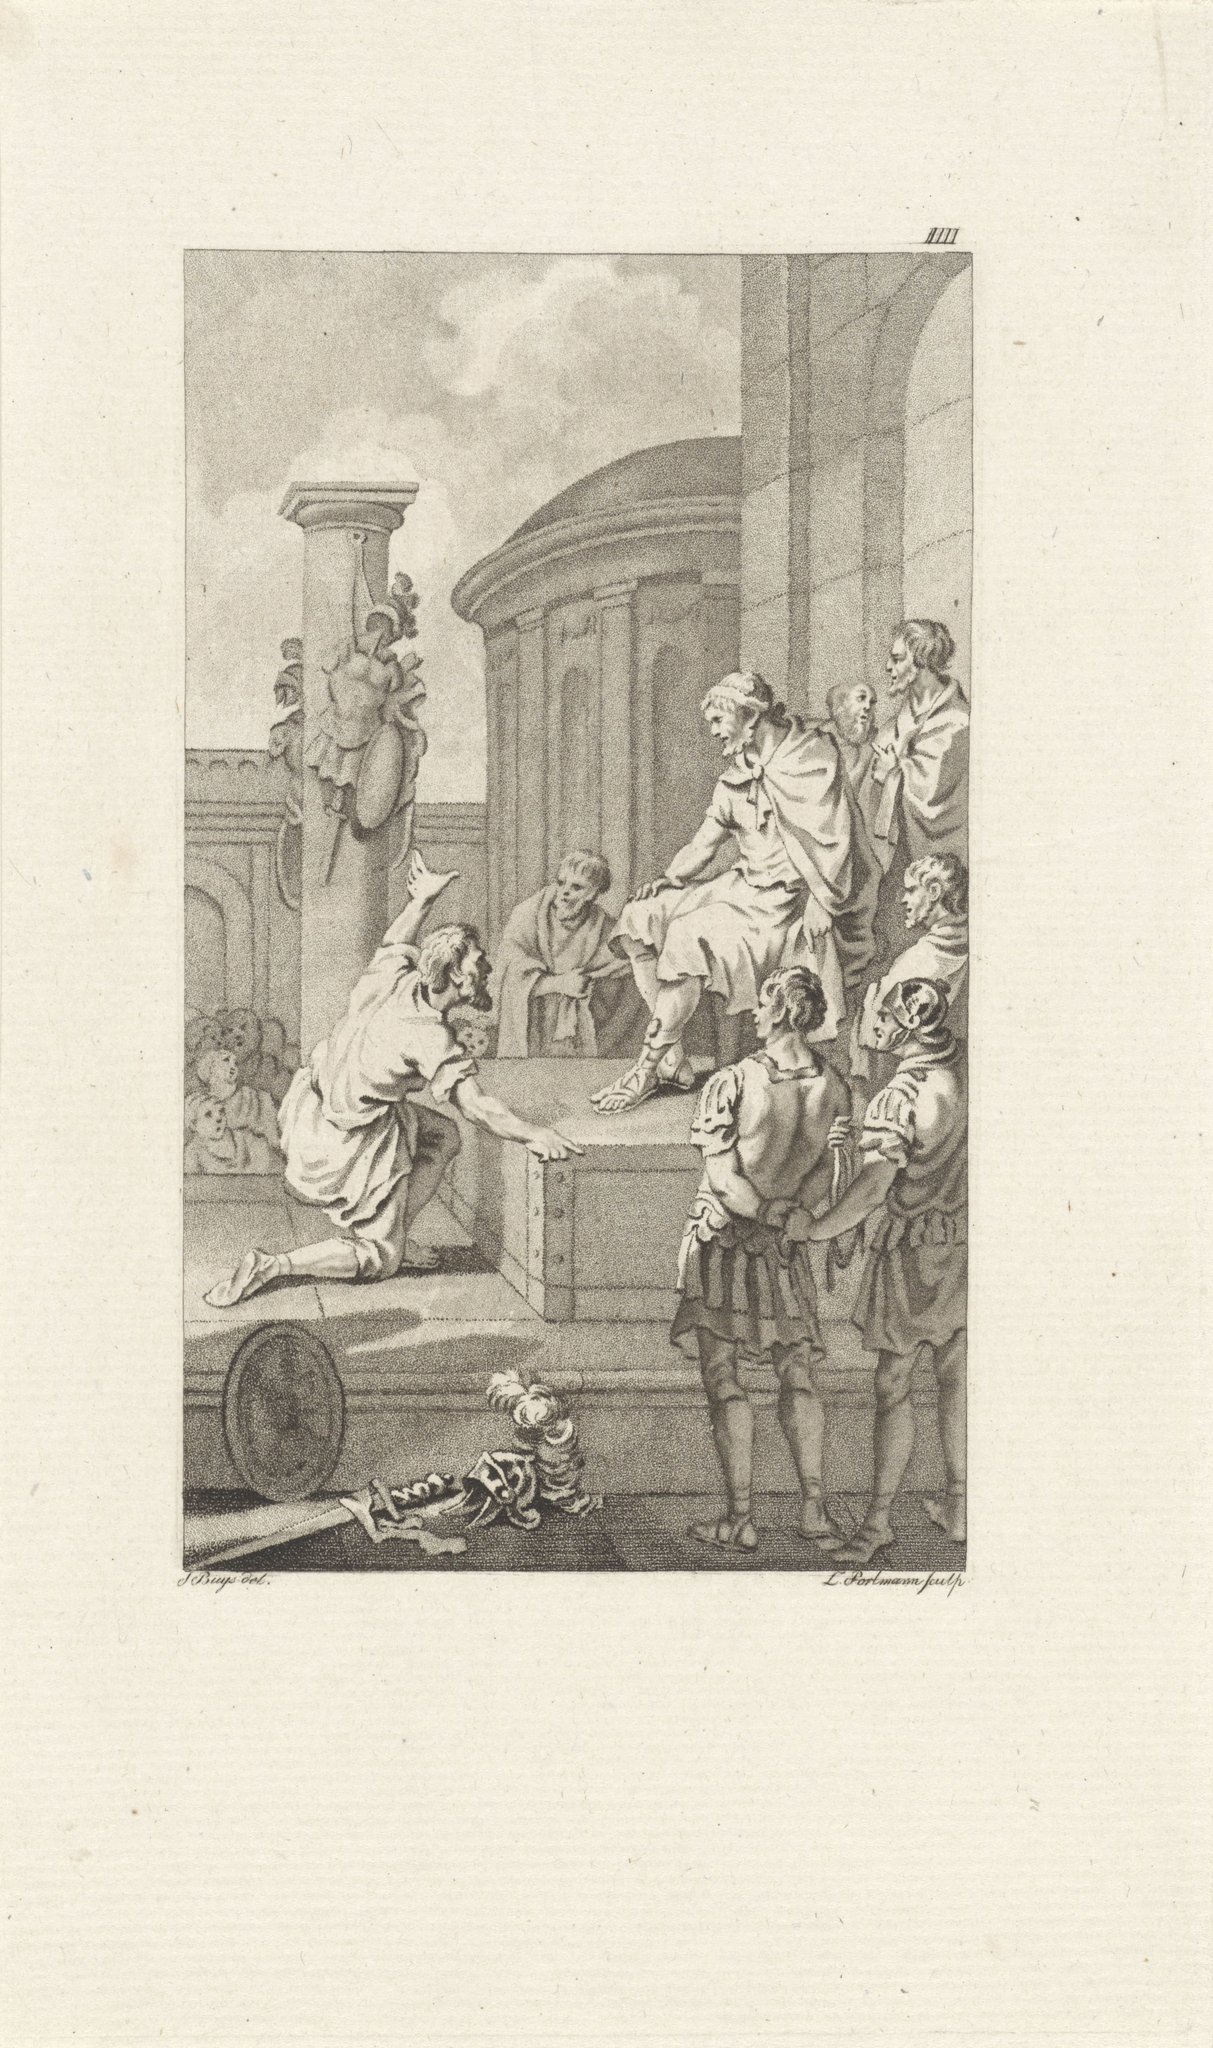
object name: print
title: Publius Horatius vrijgesproken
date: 1793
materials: paper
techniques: stippled etching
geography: utrecht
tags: horatius is tried, but acquitted after an appeal by his father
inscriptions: collector's mark: Lugt 2228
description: Publius Horatius heeft zijn zuster Horatia gedood en is vervolgens aangeklaagd en veroordeeld voor hoogverraad. Op voorspraak van zijn vader wordt hij vrijgesproken. Zijn vader wijst de volksvergadering op de wapenrusting van de Curiatii, die aan een pilaar is opgehangen.